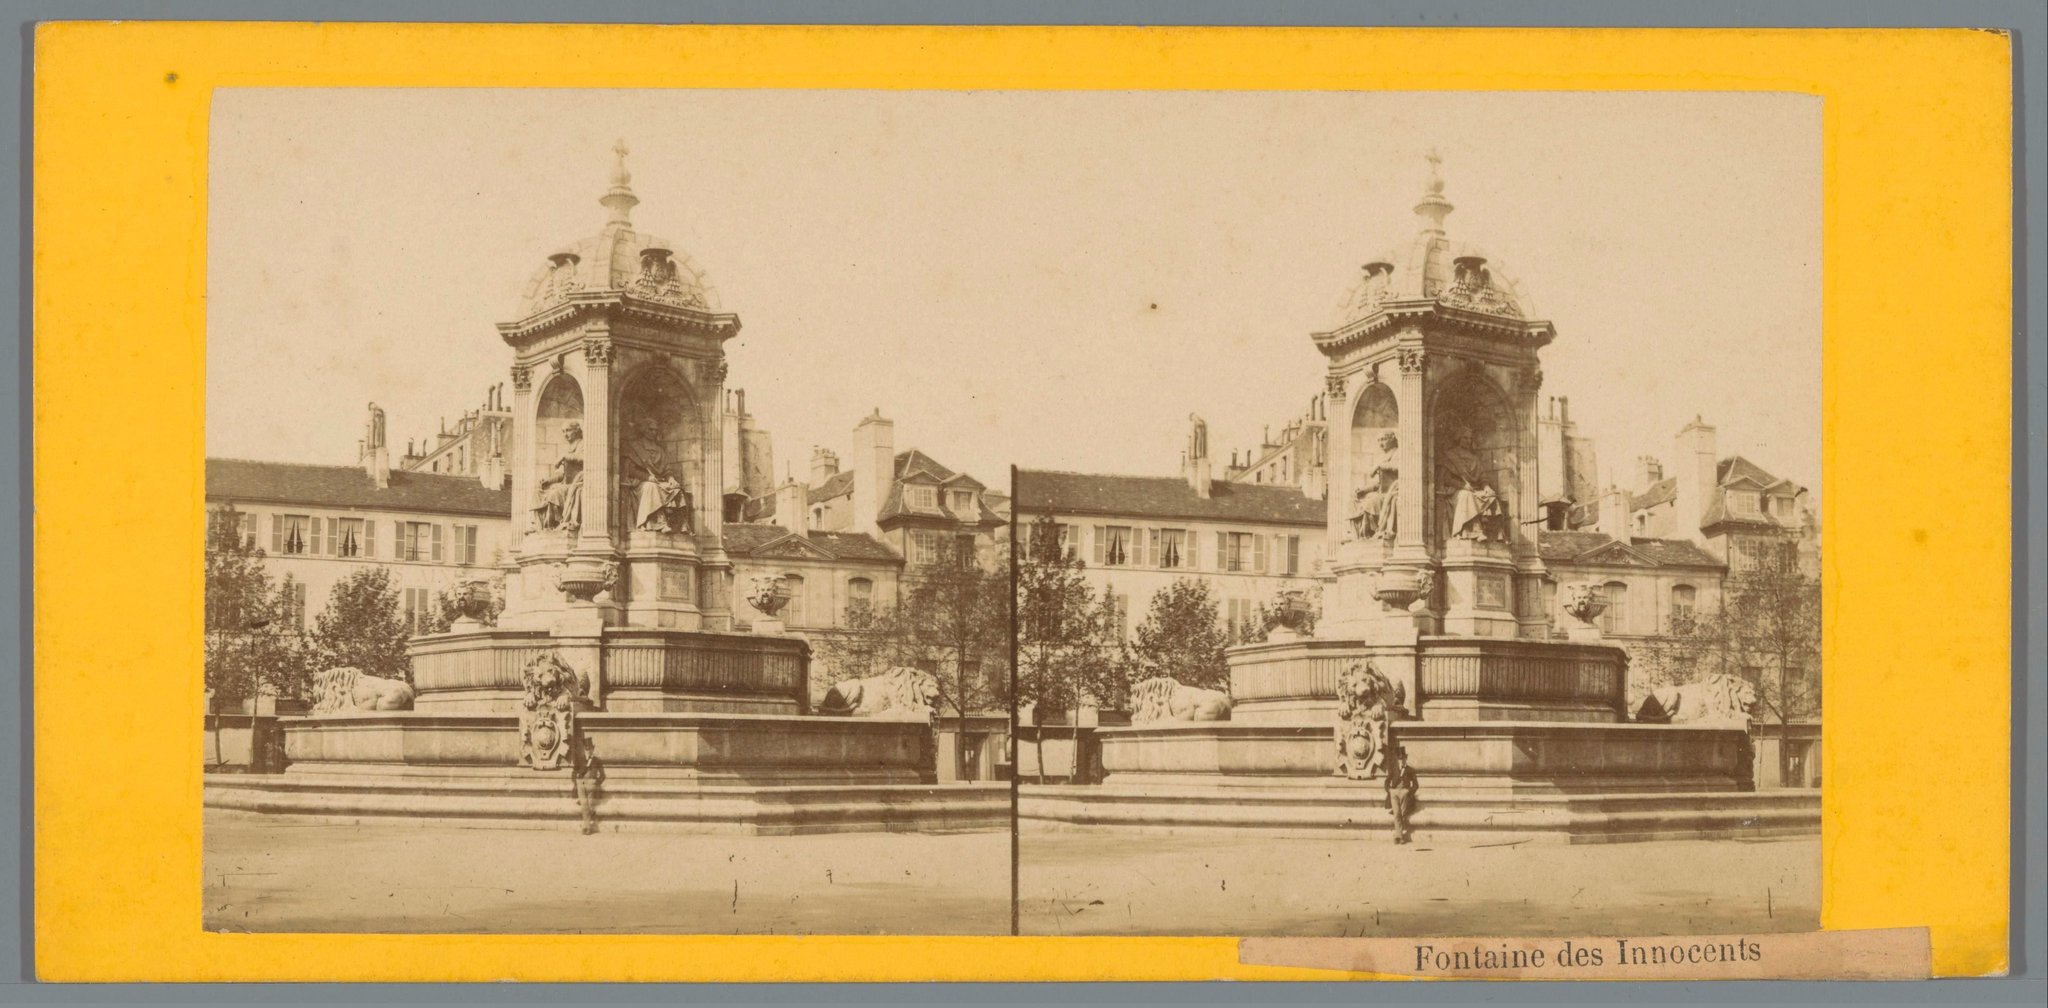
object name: stereograph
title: Gezicht op de Fontaine des Innocents in Parijs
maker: Anonymous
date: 1850-1880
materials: cardboard, photographic support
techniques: albumen print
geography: paris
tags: ornamental fountain